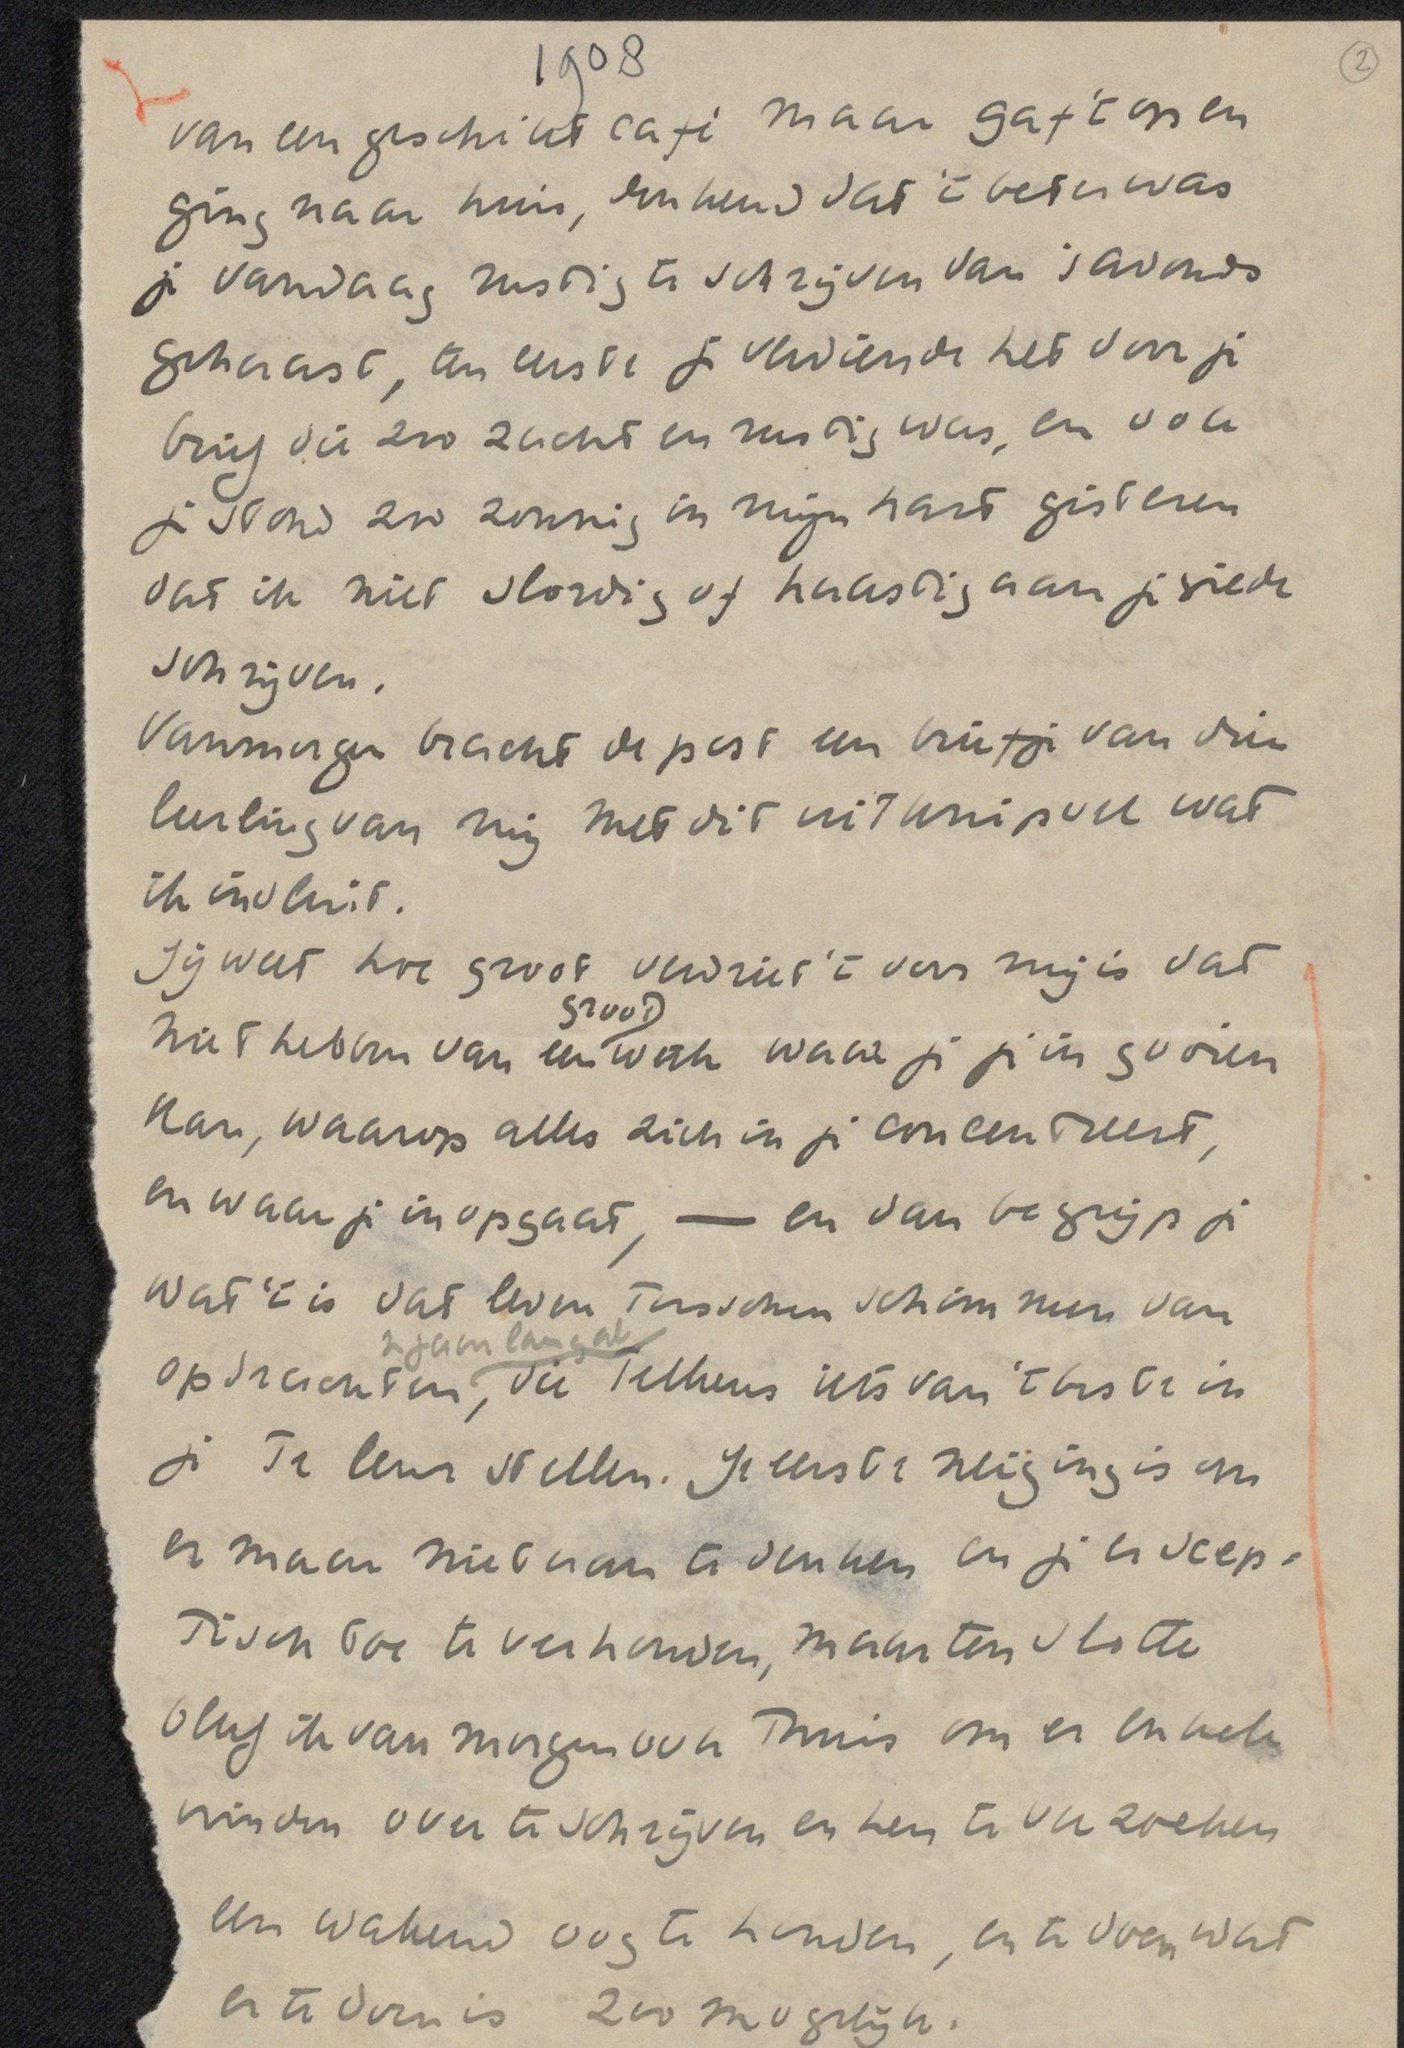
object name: letter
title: Brief aan Ina van Eibergen Santhagens-Waller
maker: richard nicolaüs roland holst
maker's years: 1868-1938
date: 1878-1938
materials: ink, paper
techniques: pen, writing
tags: haarlem, amsterdam, print maker, ina van eibergen santhagens-waller, passions, emotions, affections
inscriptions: collector's mark: ‘RPK’